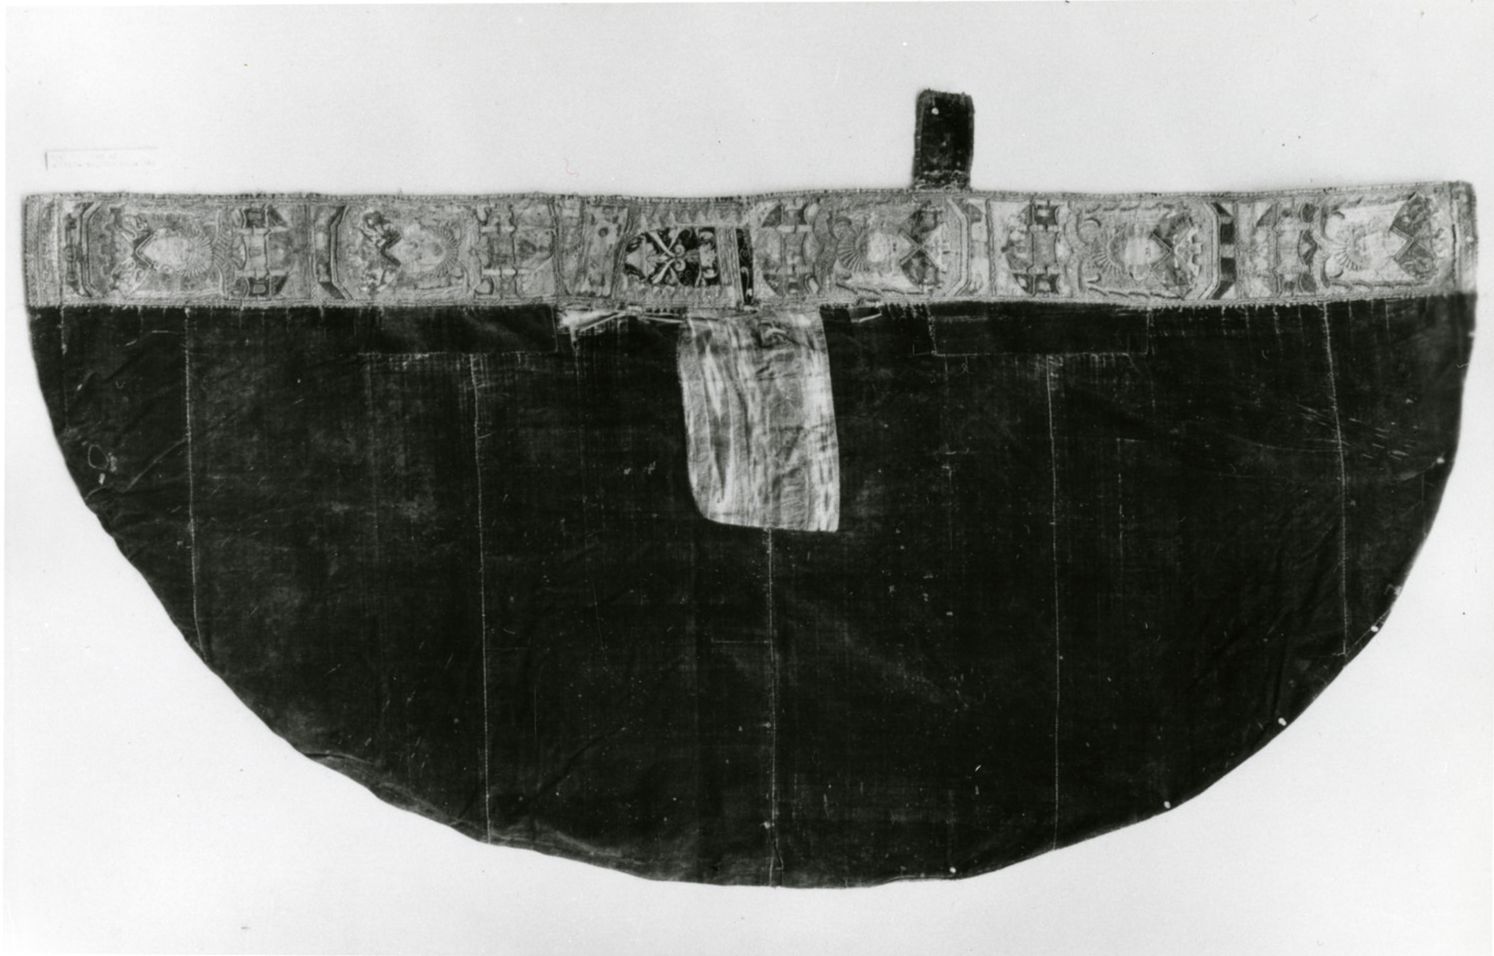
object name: cope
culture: spanish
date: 1500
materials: velvet